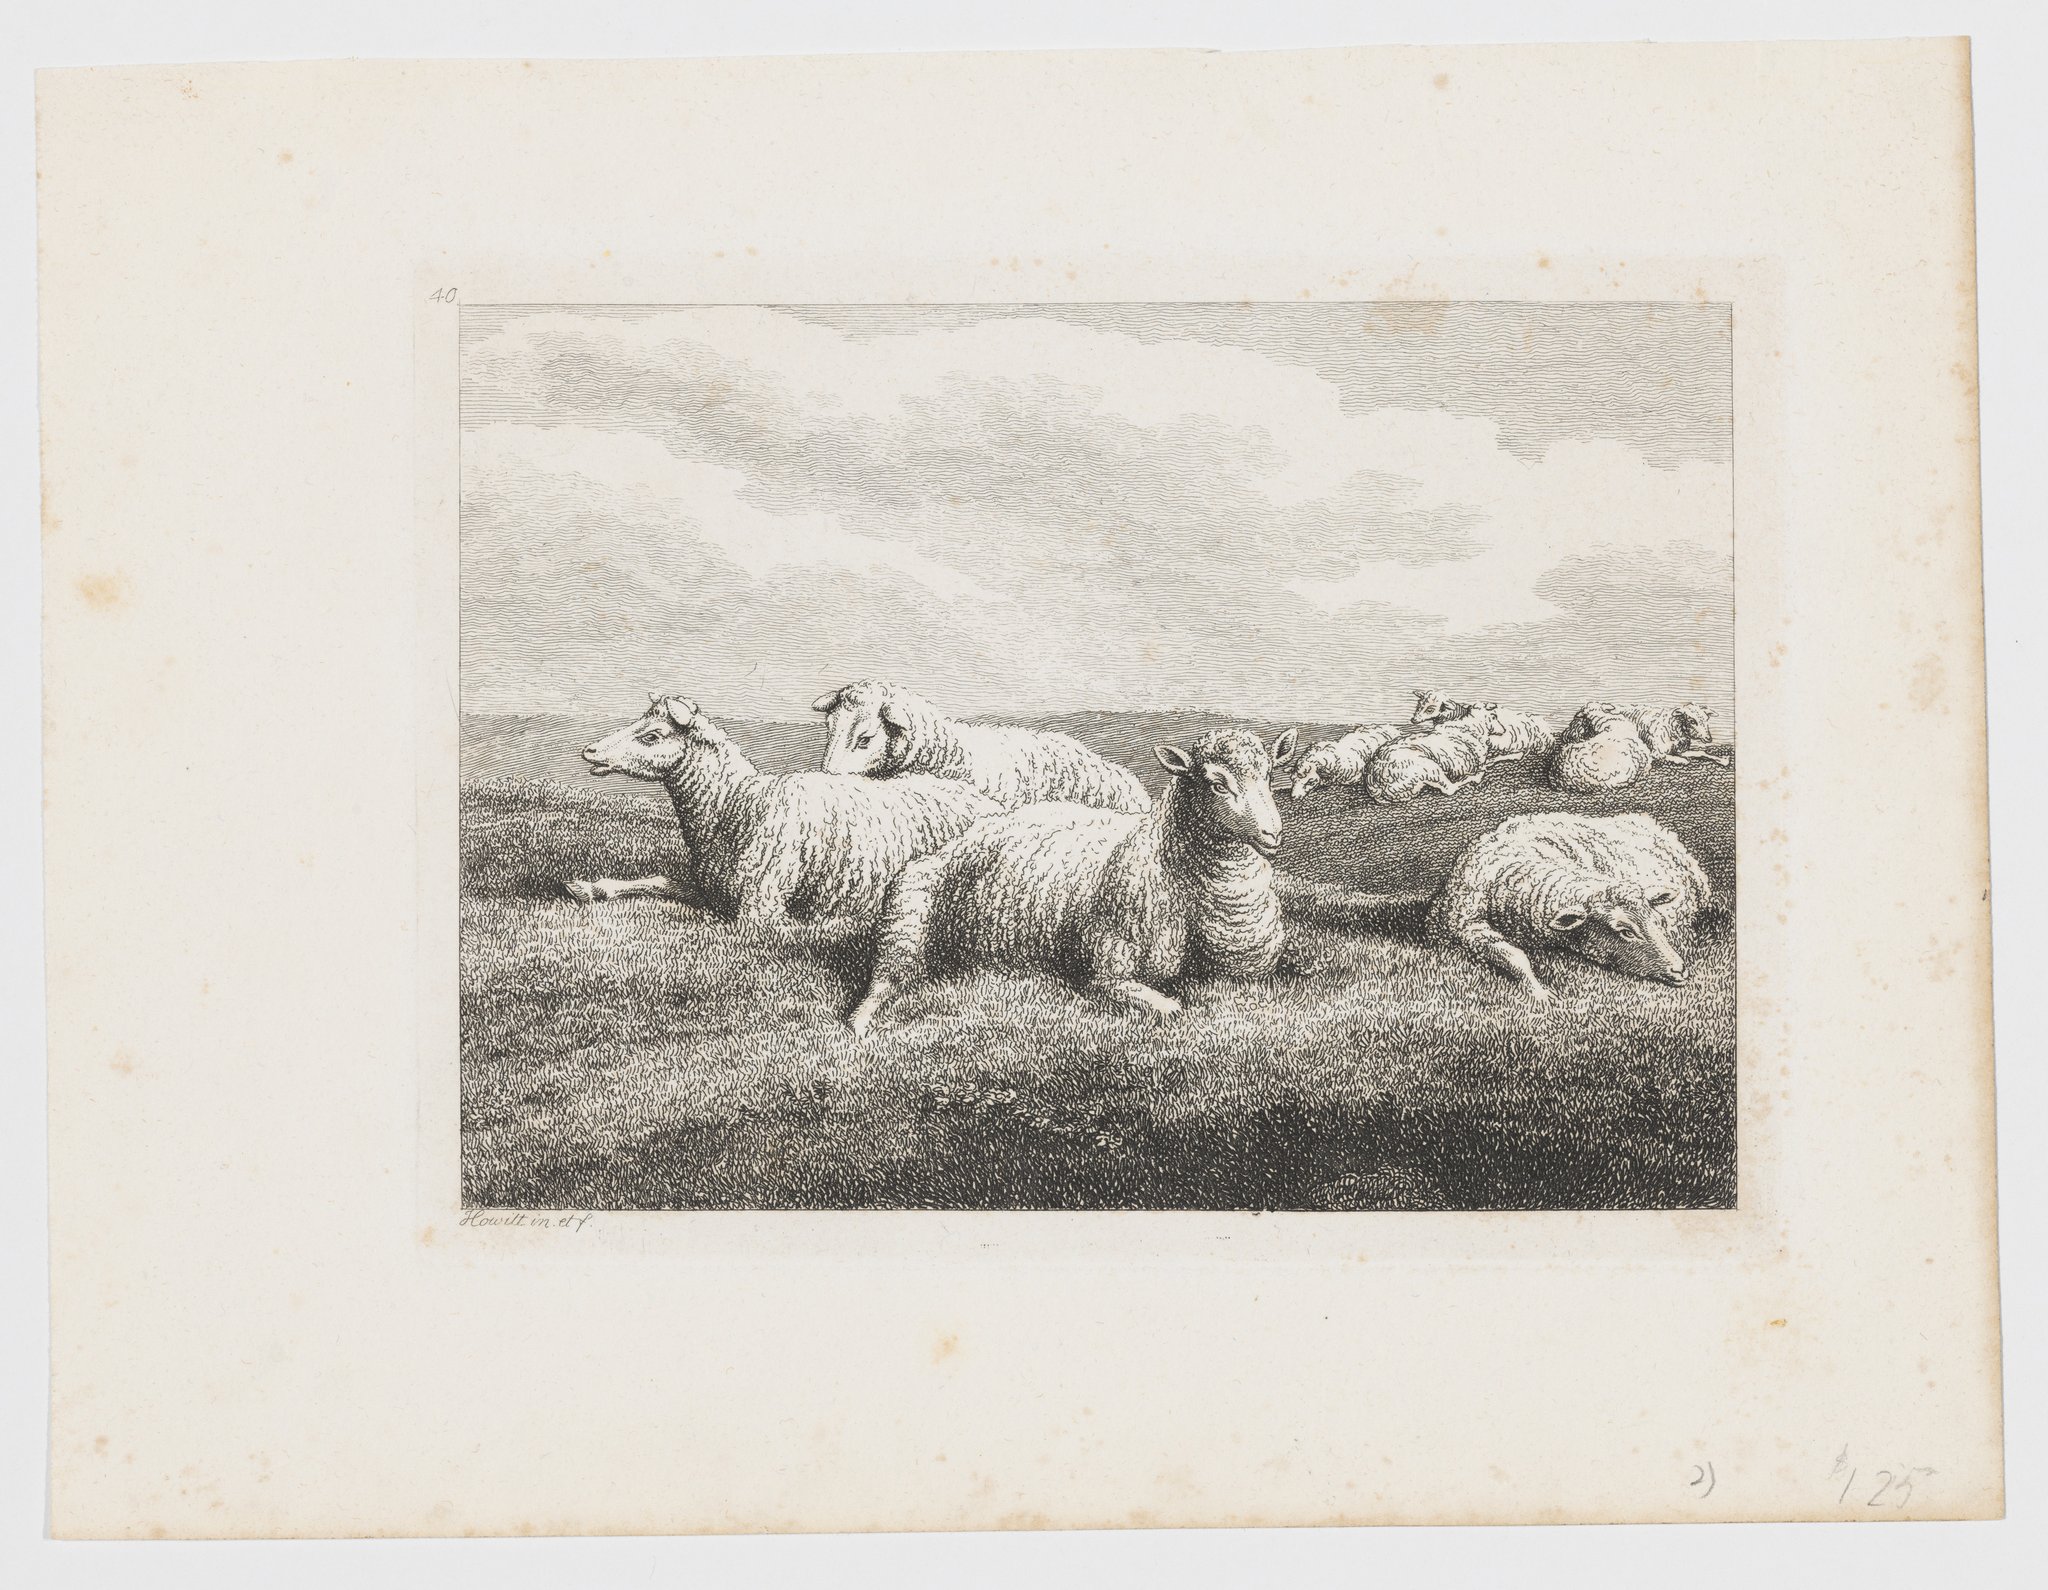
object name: print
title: Sheep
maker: samuel howitt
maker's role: artist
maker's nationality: british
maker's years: 1756-1823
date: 1800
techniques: etching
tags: sheep